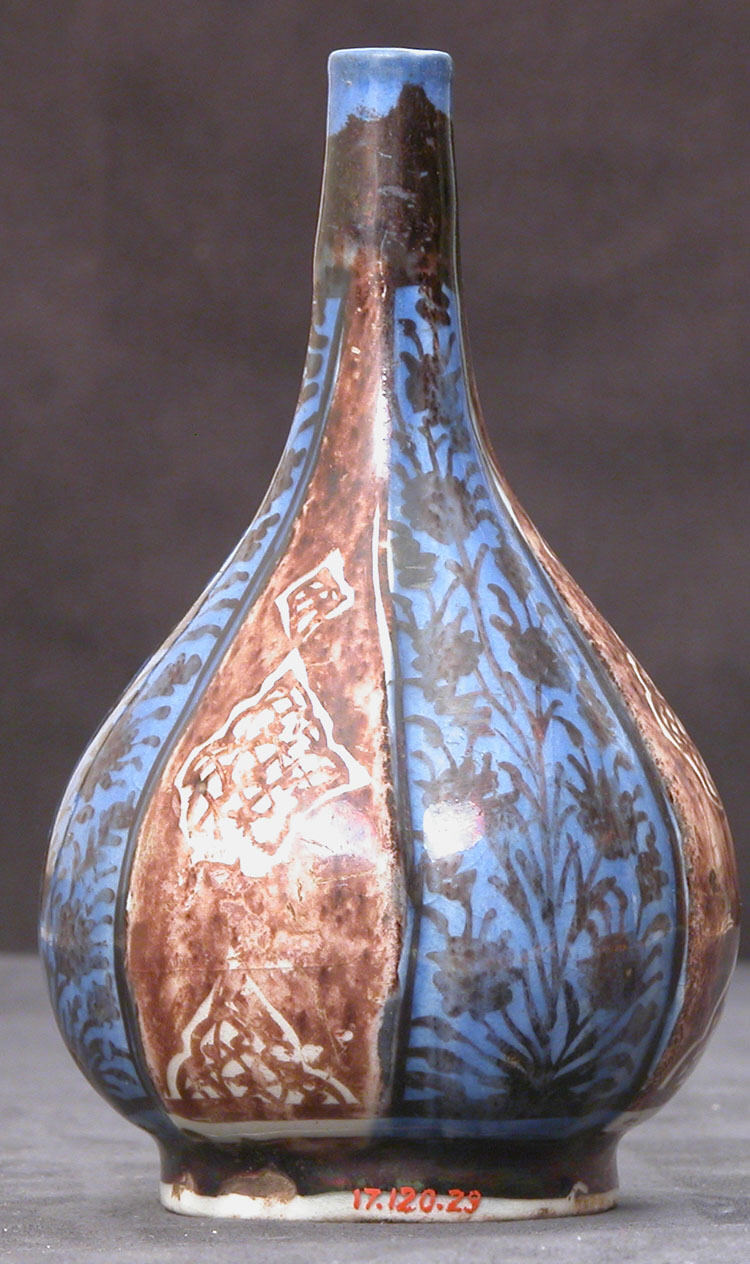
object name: bottle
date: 1701-1800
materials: glaze, stonepaste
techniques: luster painting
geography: iran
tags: flowers